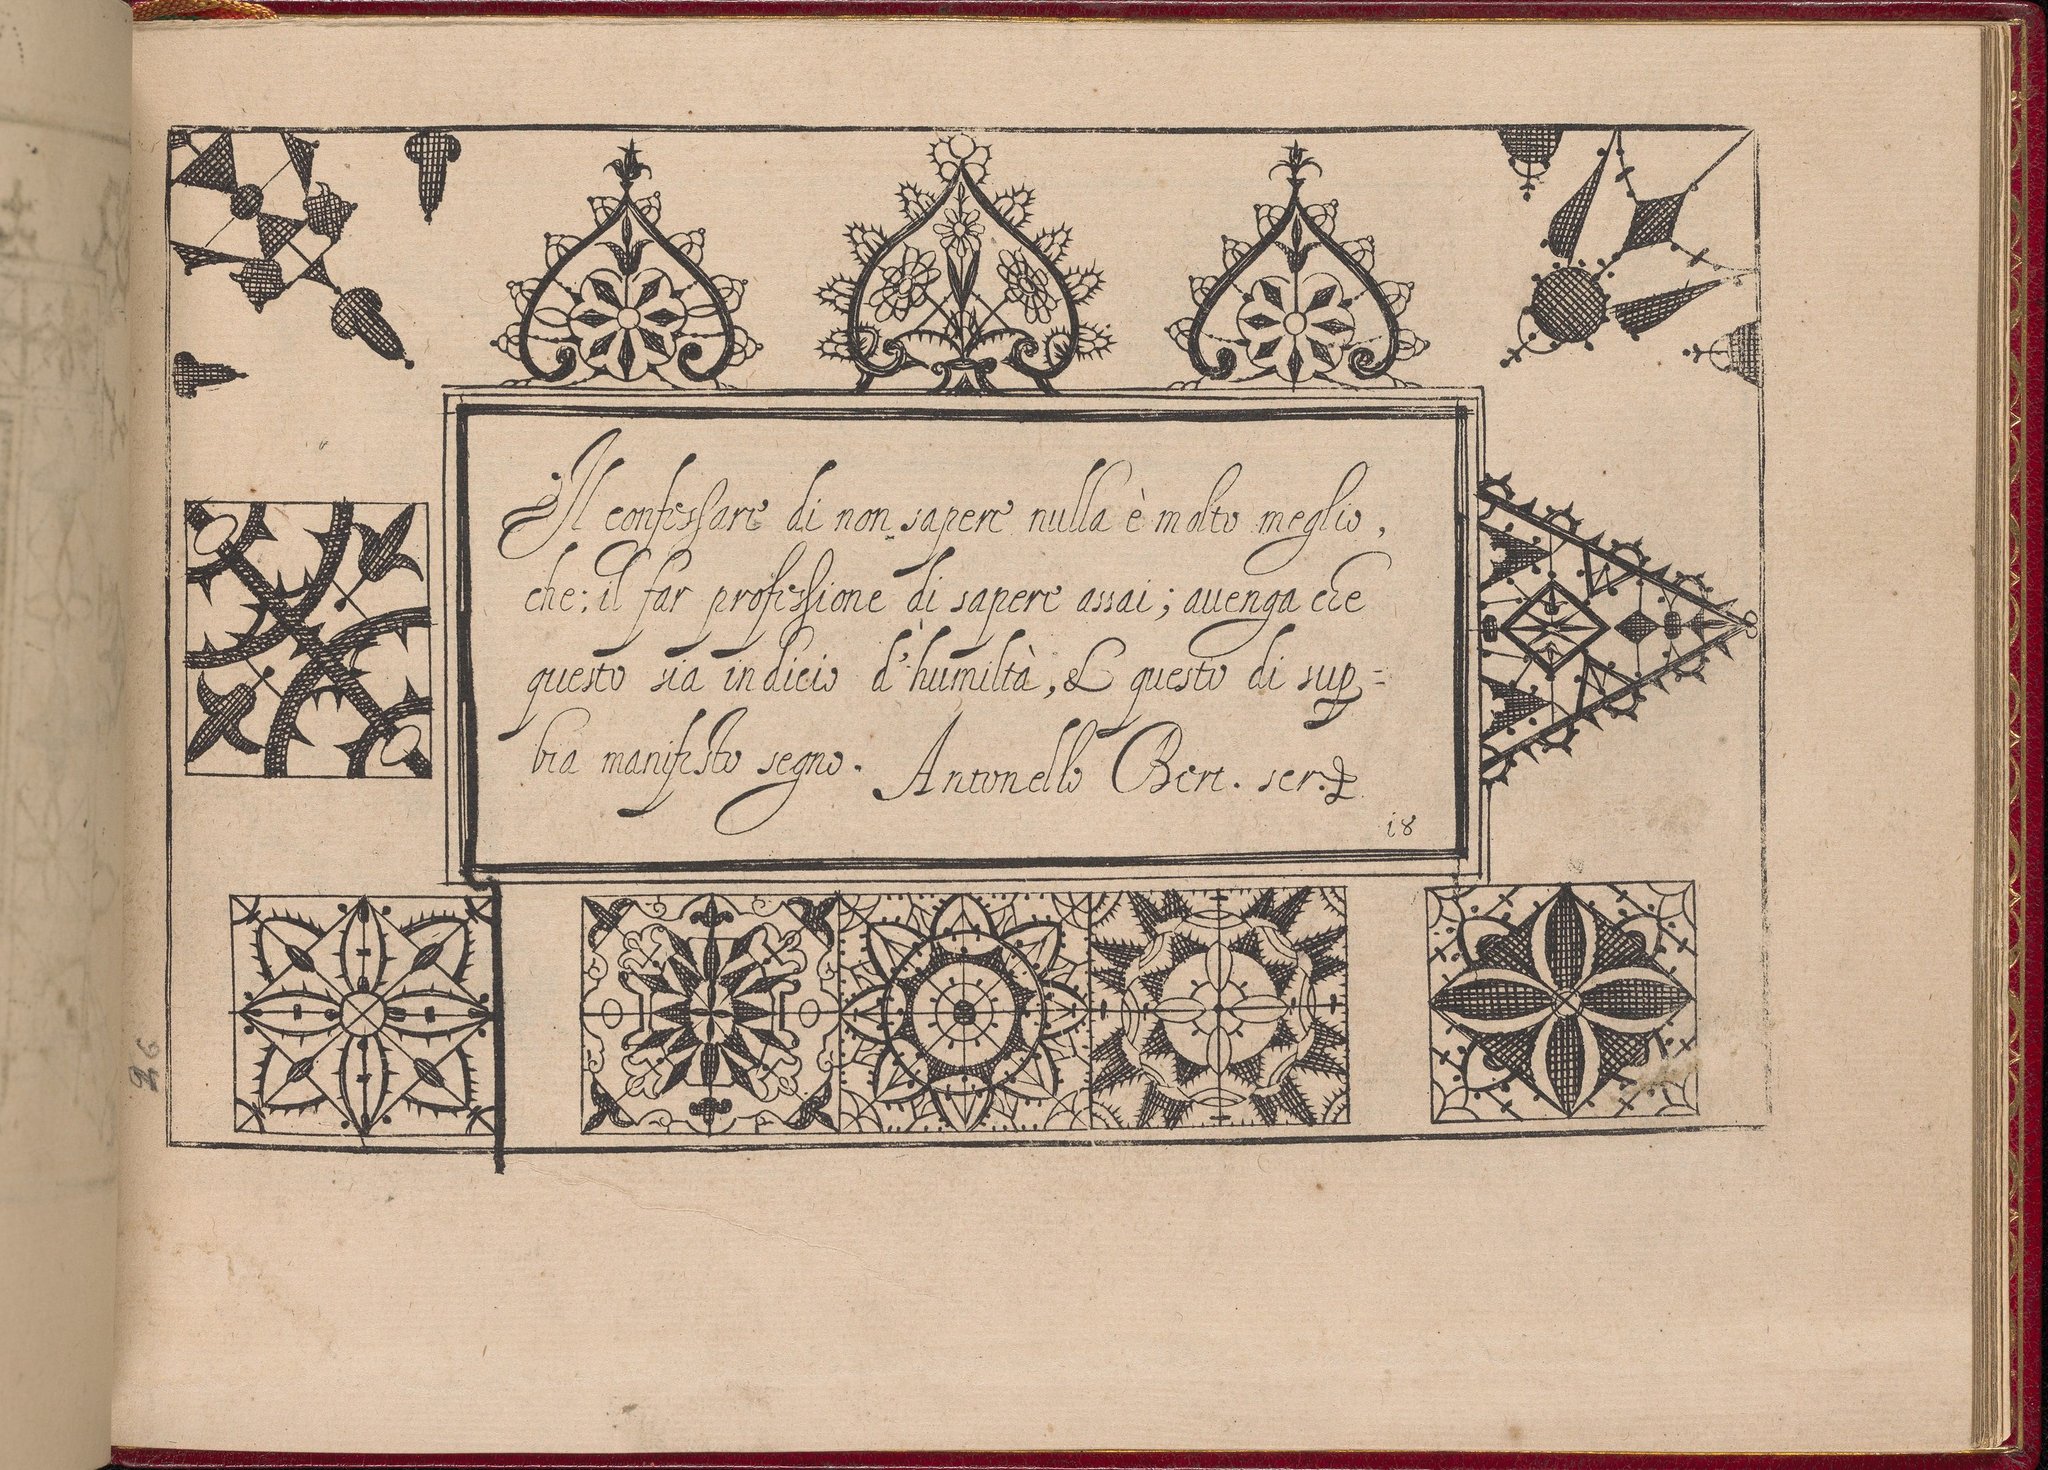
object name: book print ornament architecture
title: Ghirlanda: Di sei vaghi fiori scielti da piu famosi Giardini d'Italia, page 26 (recto)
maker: pietro paulo tozzi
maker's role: designer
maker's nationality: italian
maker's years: 1593-1628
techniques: drawing, etching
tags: ornament